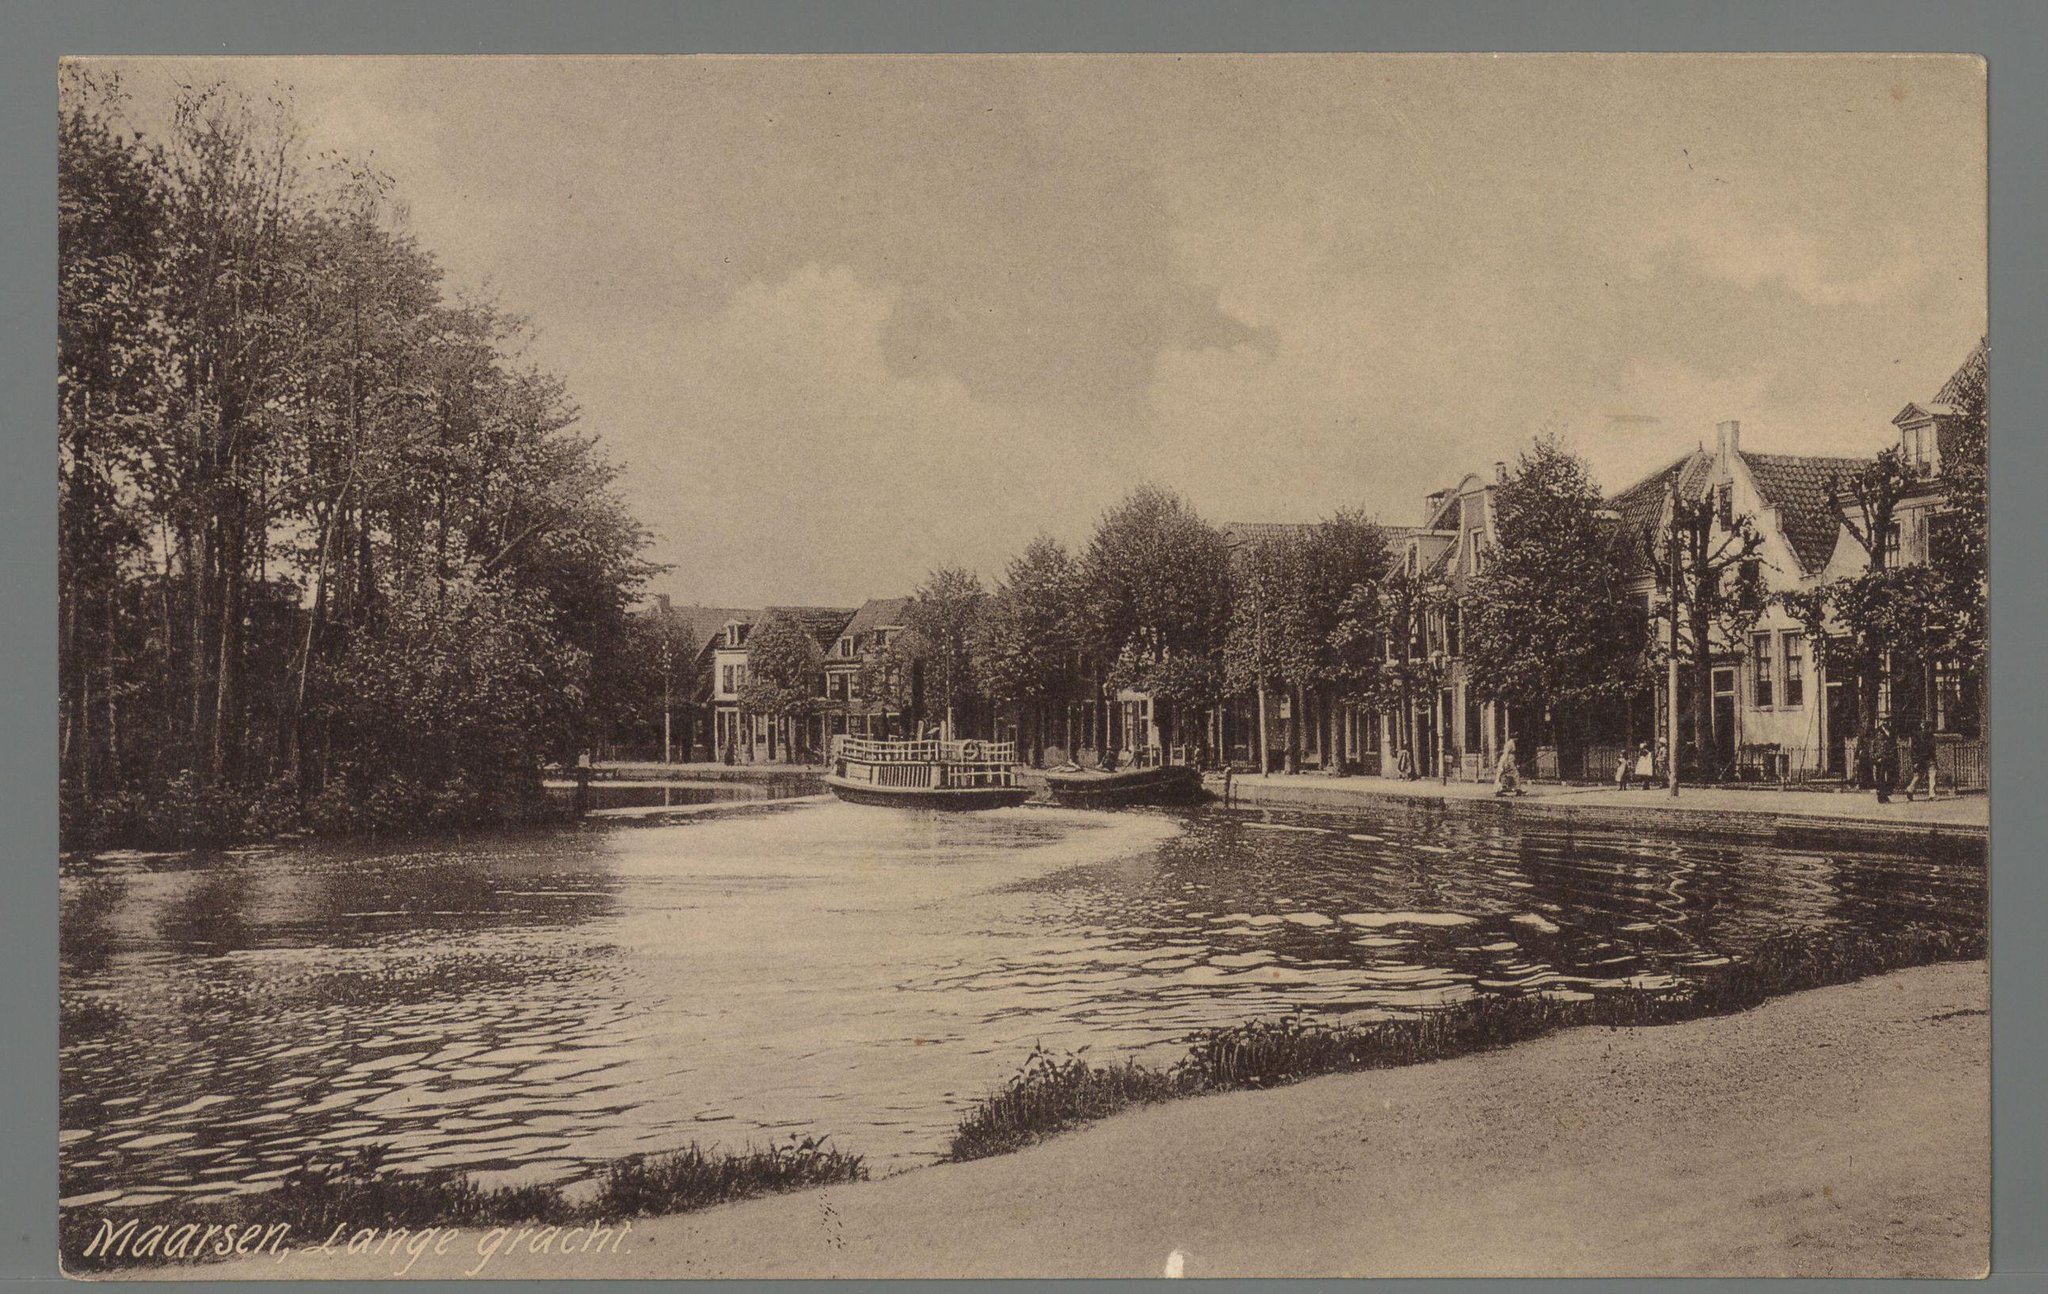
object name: photomechanical print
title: Maarsen, Lange gracht.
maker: Anonymous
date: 1906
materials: cardboard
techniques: photograph, writing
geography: leipzig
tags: canal, maarssen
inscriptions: postage stamp